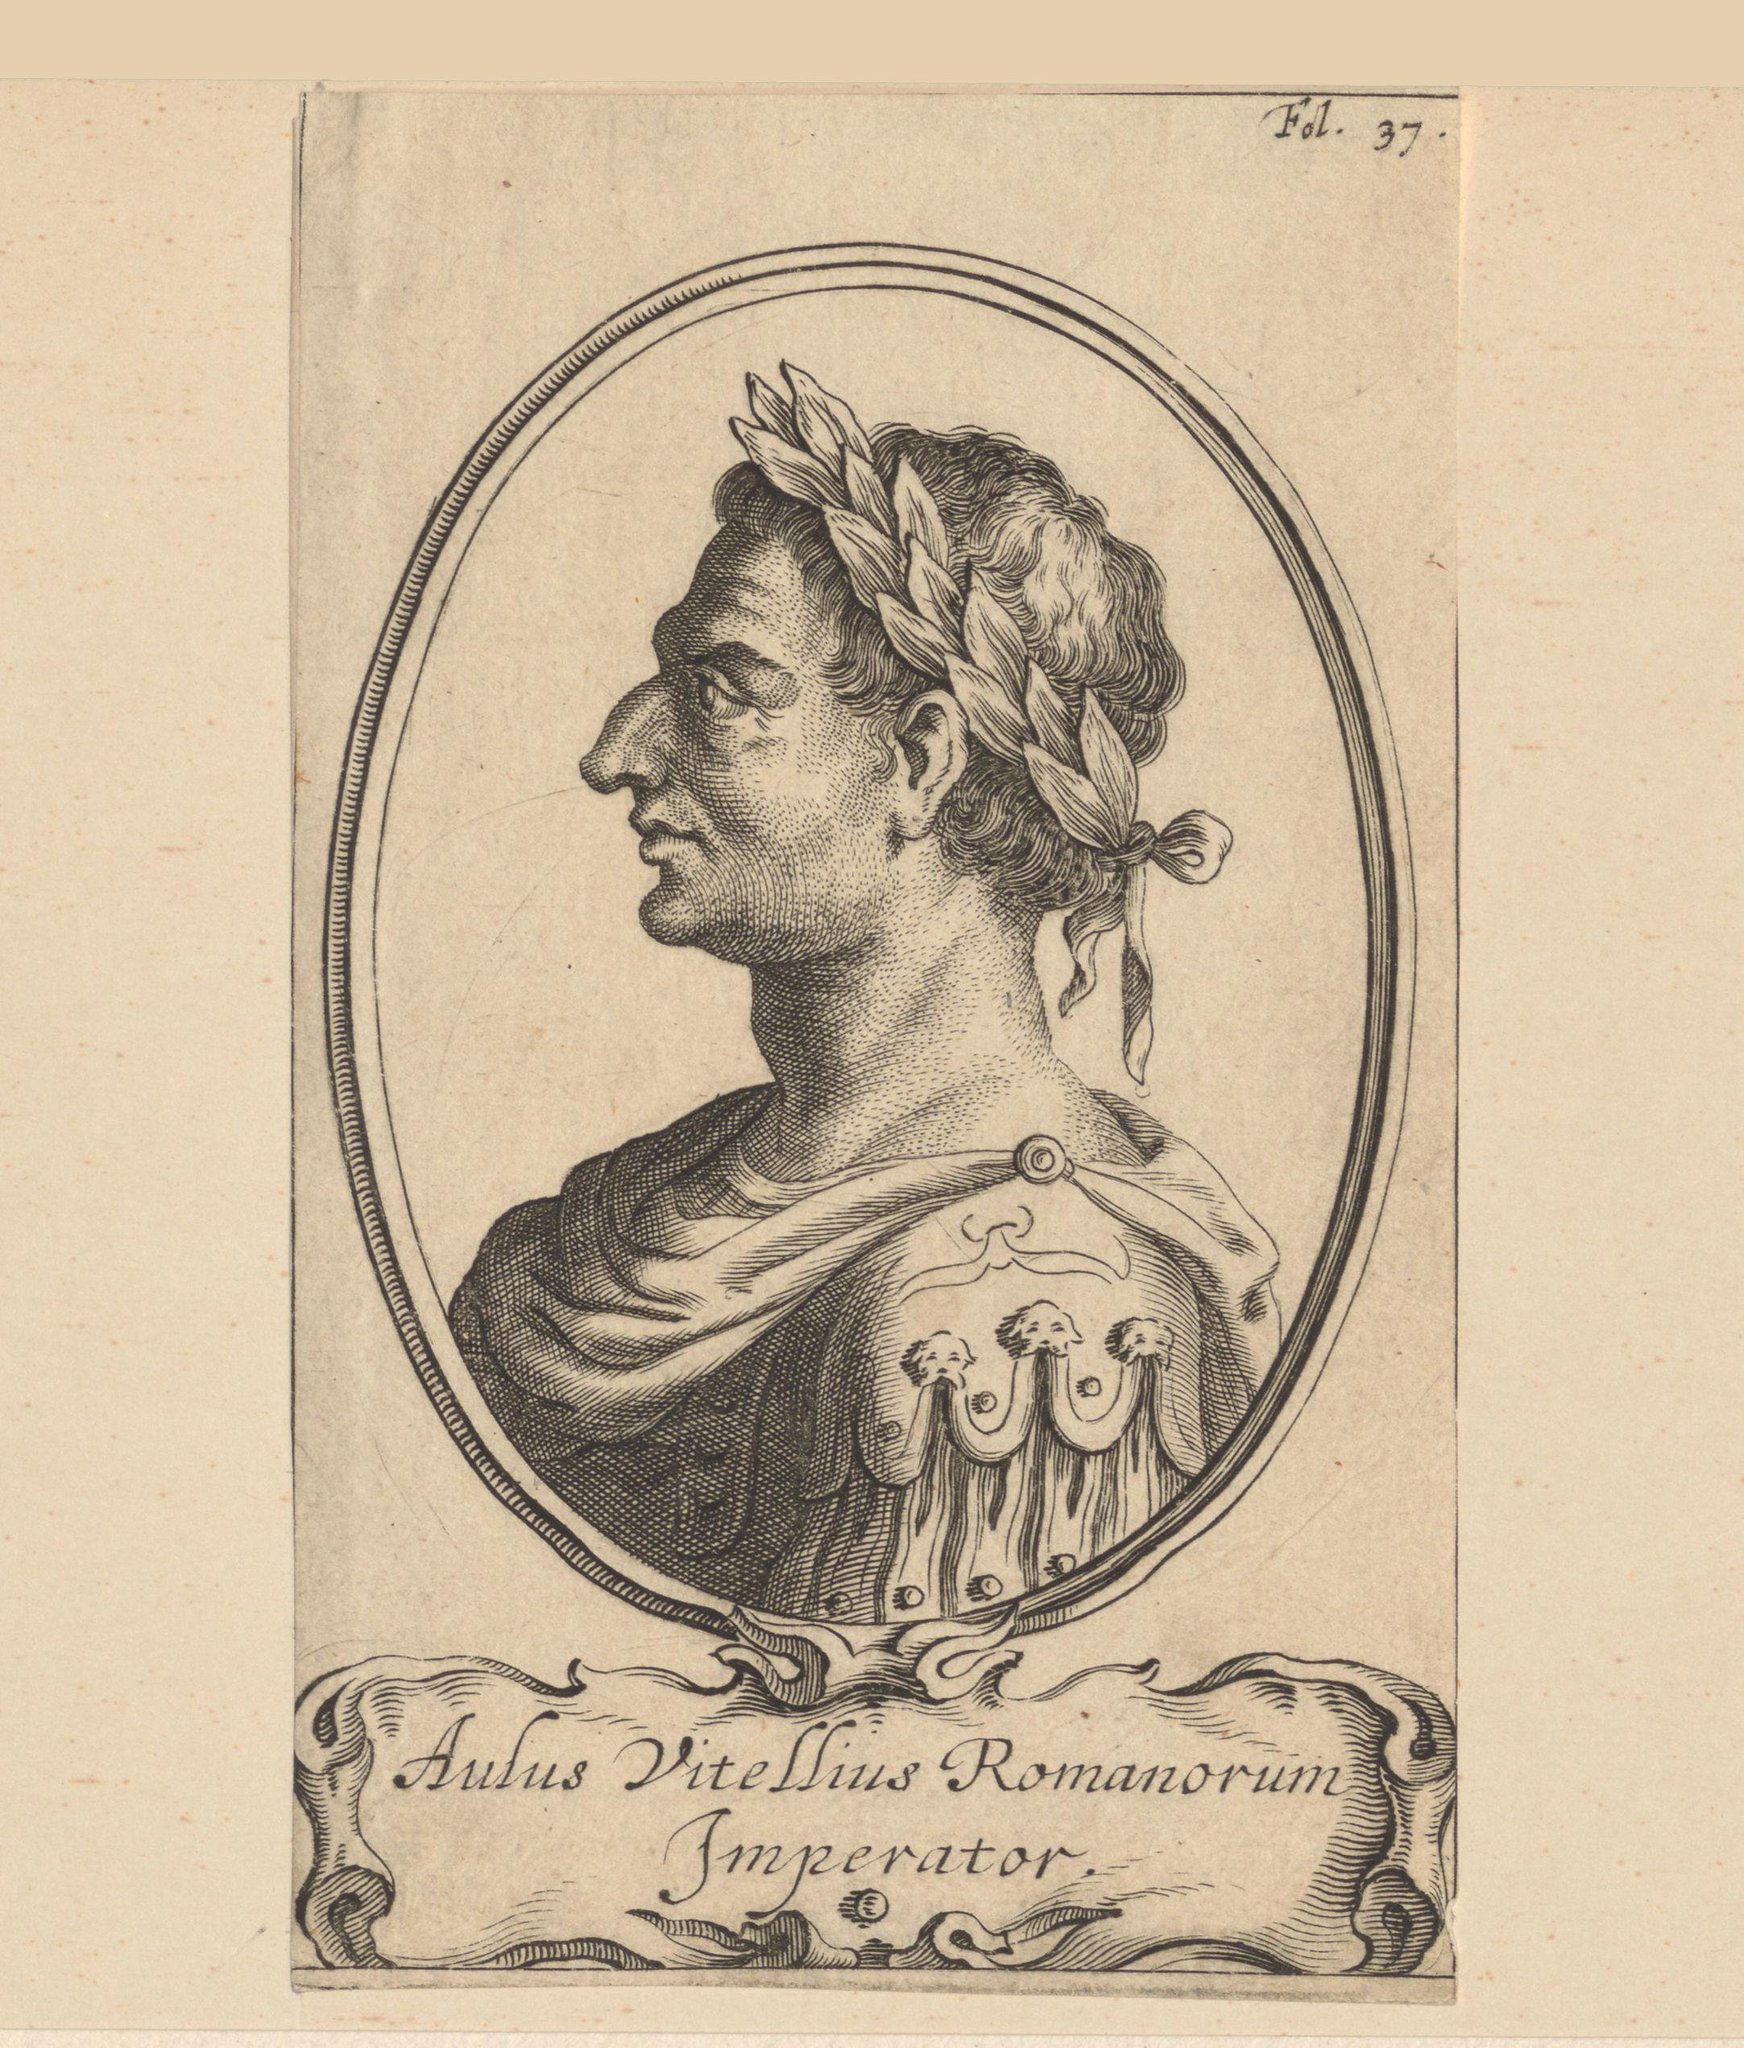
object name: print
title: Portret van keizer Vitellius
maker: Anonymous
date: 1656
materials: paper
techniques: engraving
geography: northern netherlands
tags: ornament ~ medallion, historical persons, emperor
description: Prent waarschijnlijk uit: Bos, Lambert van den. Het konincklyk treur-toonneel, ofte op- en ondergangh der keyseren (...). Dordrecht: Jacobus Savry, 1656, p. 37.